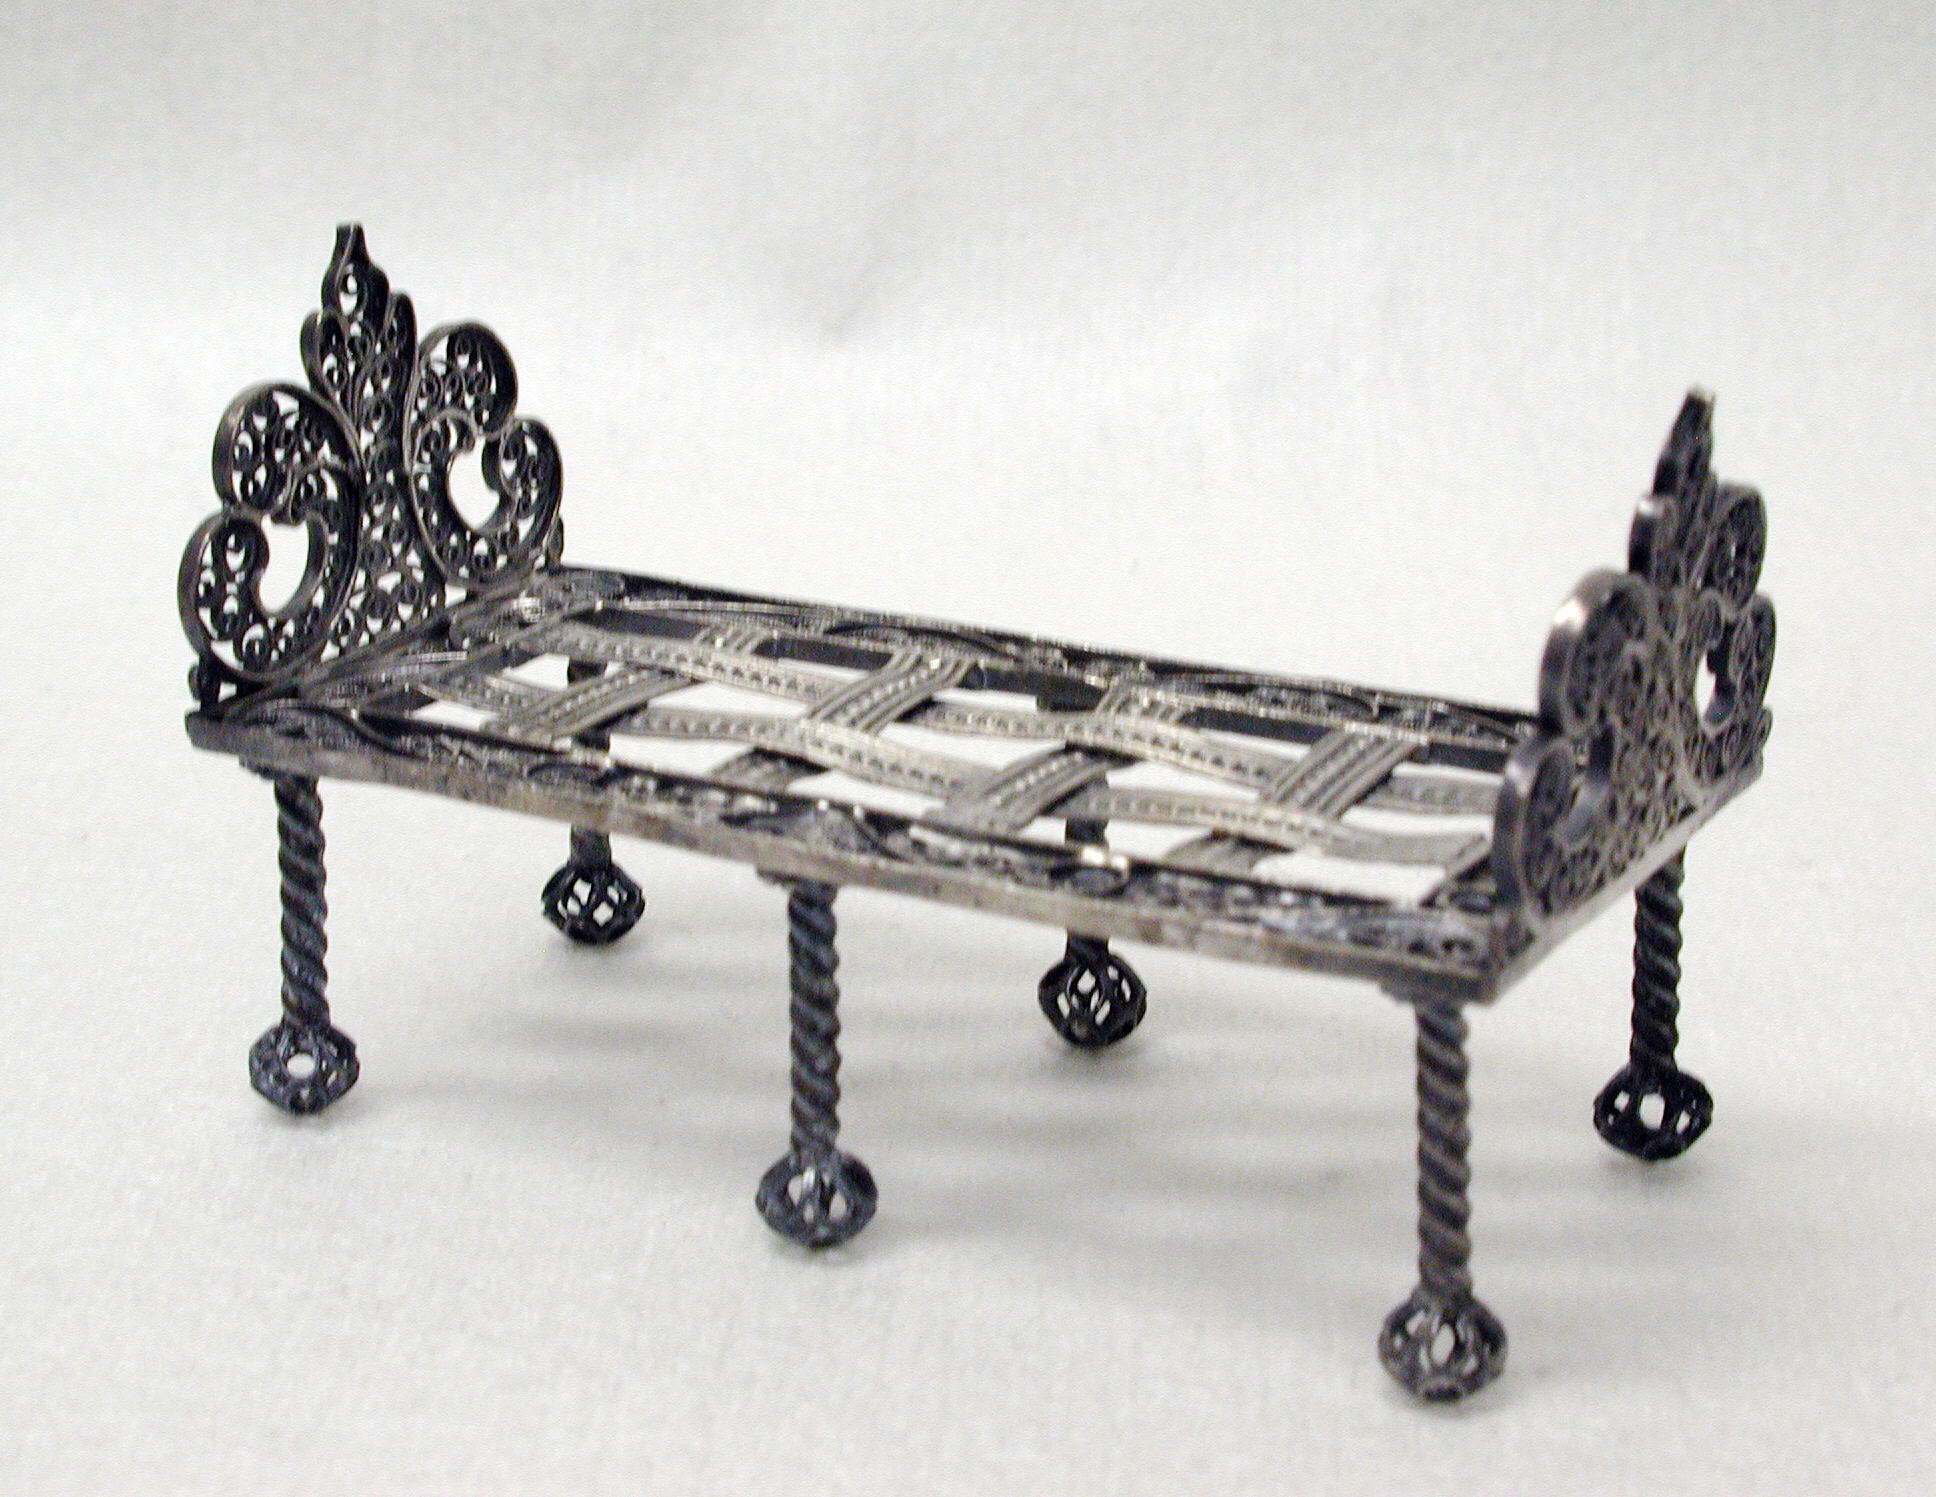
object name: daybed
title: Miniature daybed (part of a set)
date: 1601-1700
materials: silver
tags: beds